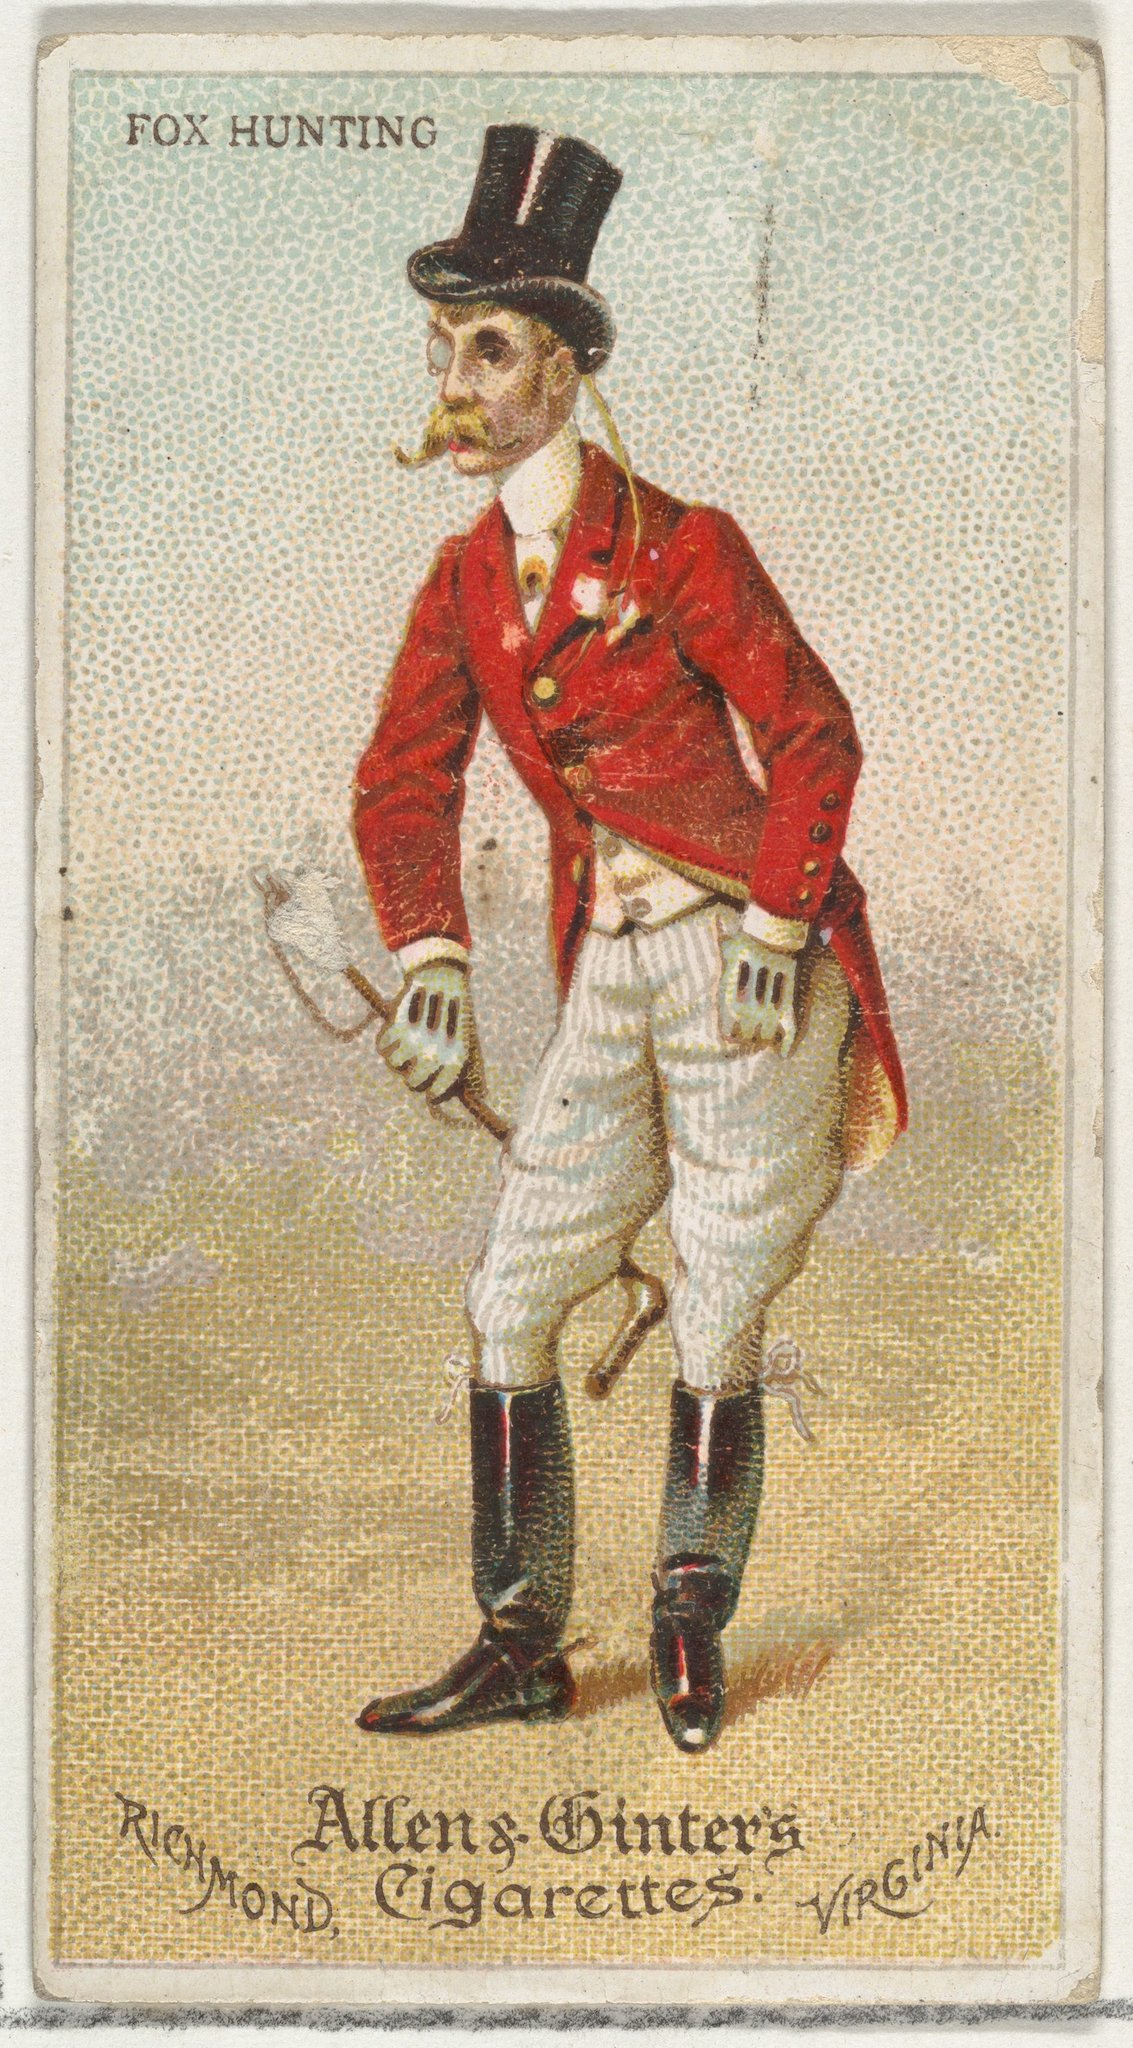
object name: print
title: Fox Hunting, from World's Dudes series (N31) for Allen & Ginter Cigarettes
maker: allen & ginter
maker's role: publisher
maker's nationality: american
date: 1888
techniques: color lithograph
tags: men